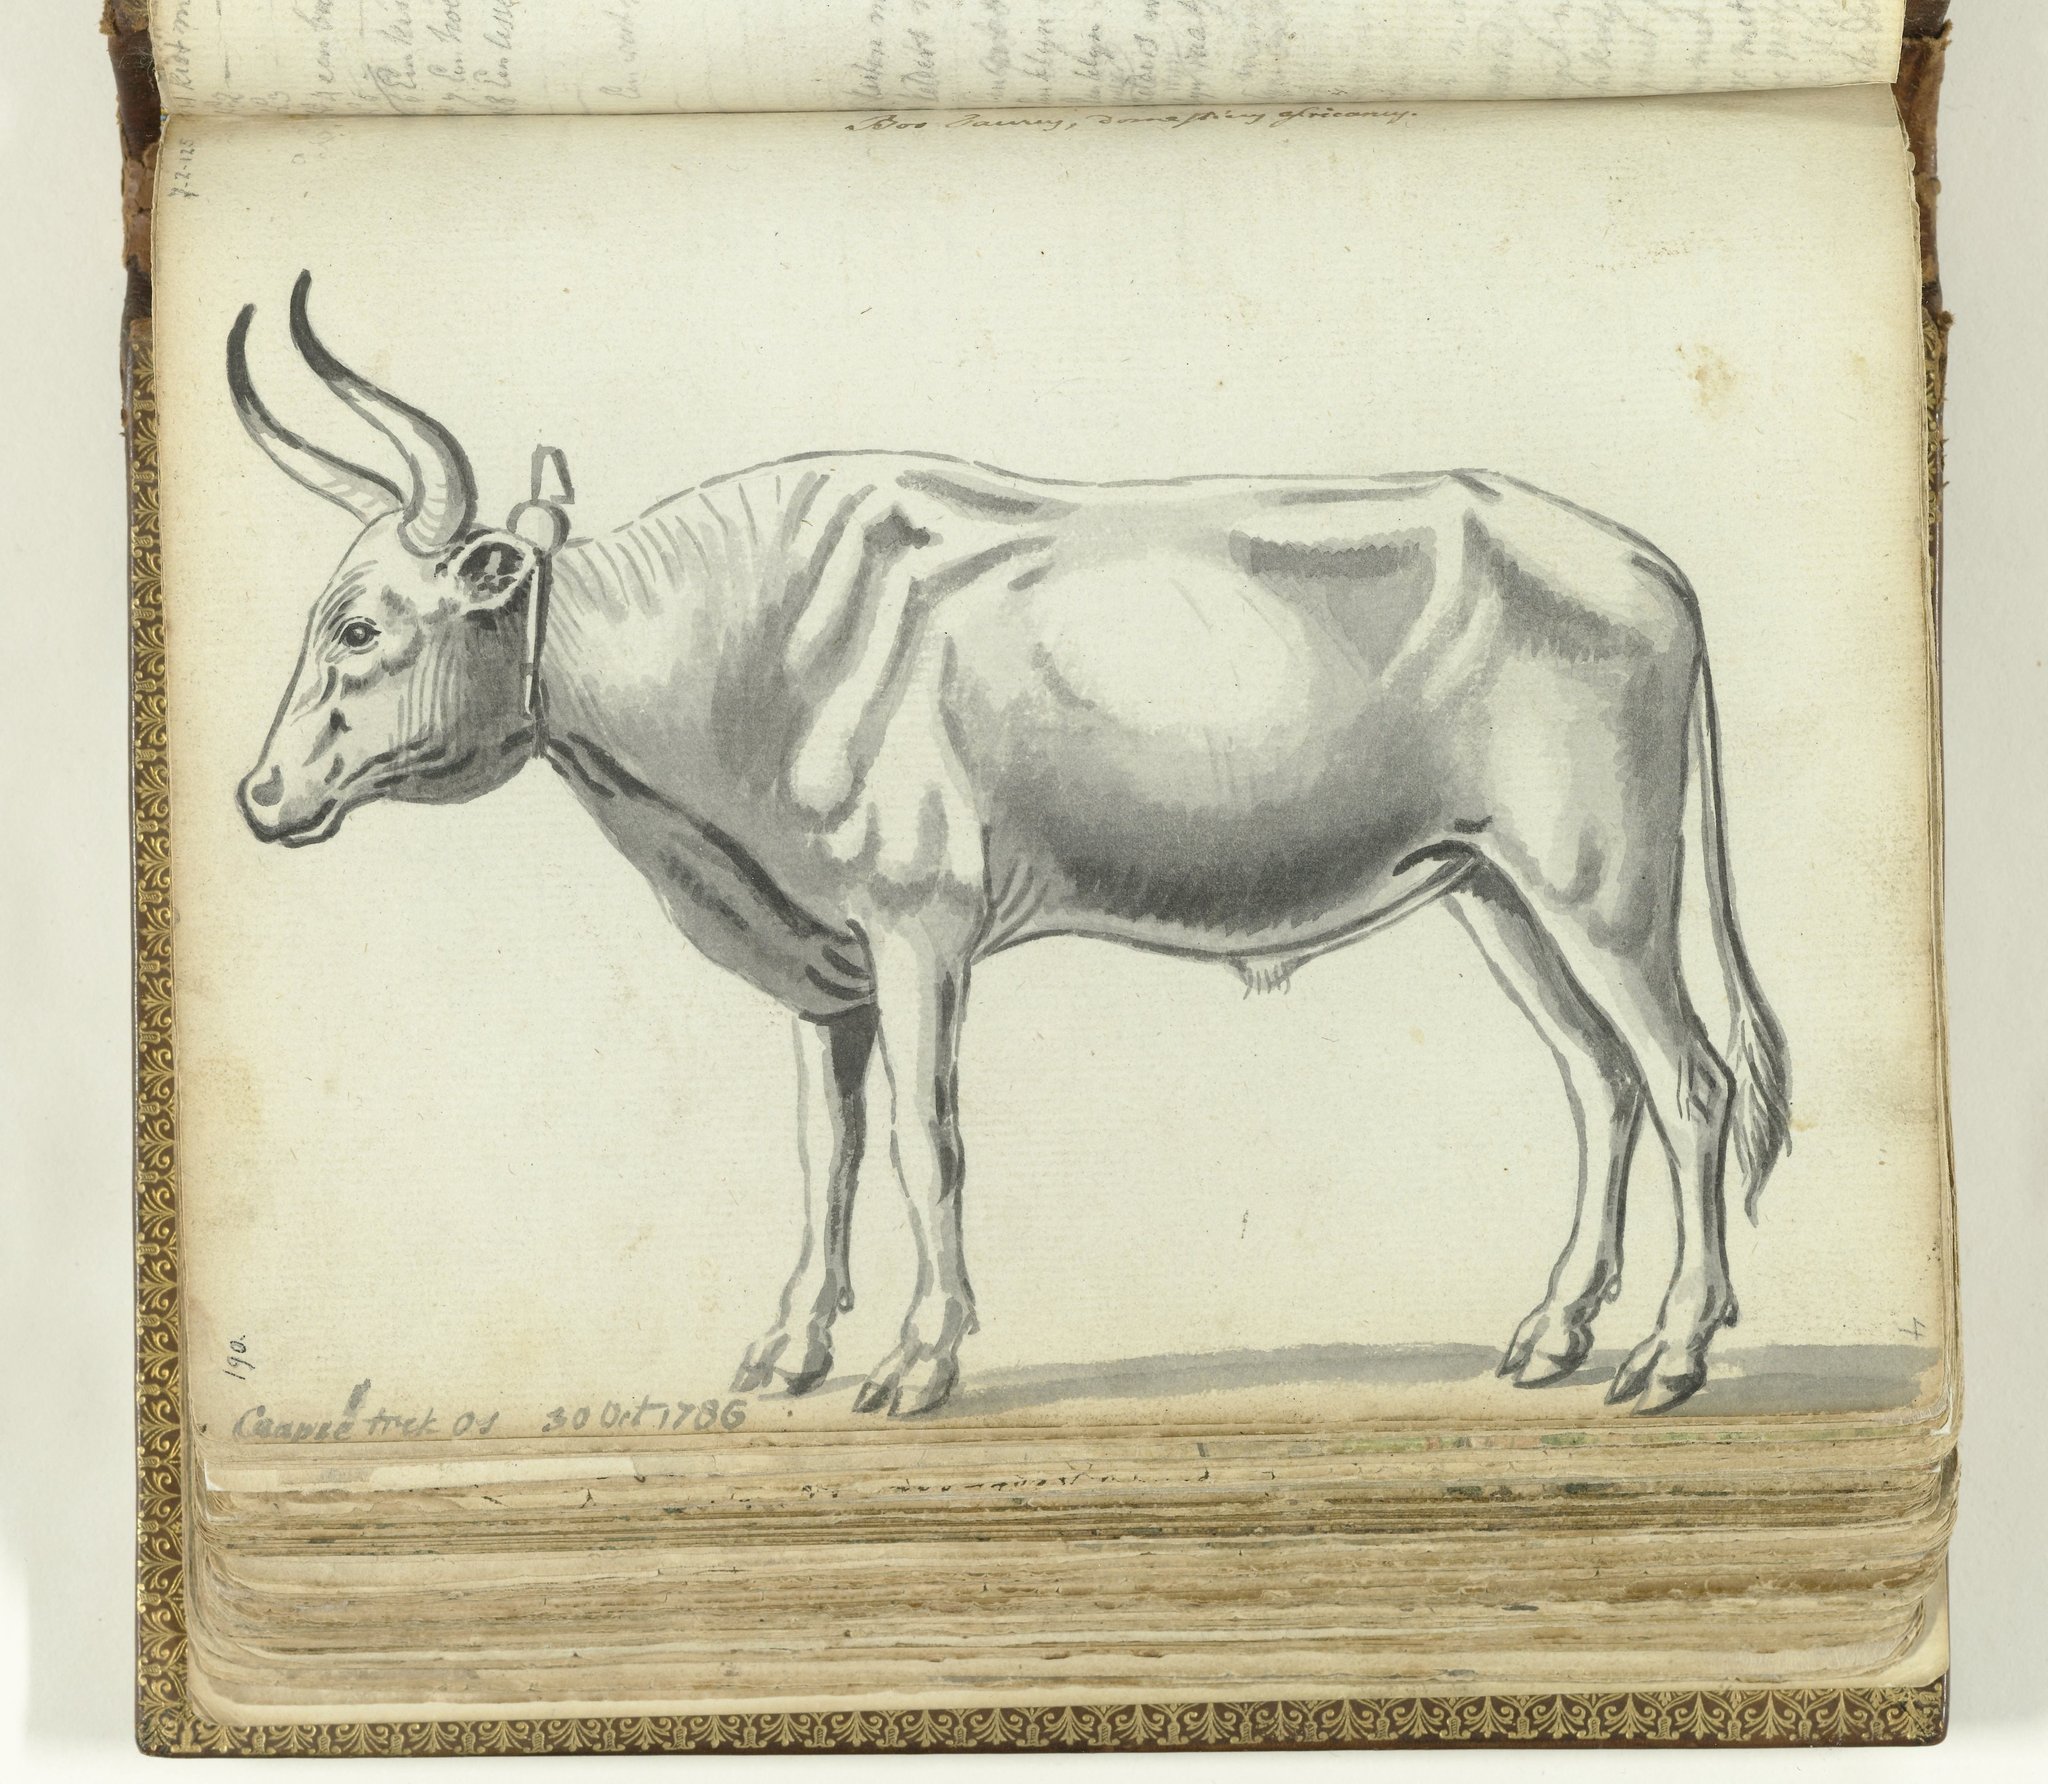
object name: drawing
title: Caapse trekos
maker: jan brandes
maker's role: draughtsman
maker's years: 1743-1808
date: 1786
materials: ink, paper, pencil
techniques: brush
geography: south africa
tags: ox, cape of good hope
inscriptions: inscription: ‘Caapse trek os 30 oct 1786.’, inscription: ‘Bos taurus, domesticus africanus.’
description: Zwartwittekening van een rund met een soort halster om zijn nek, zijaanzicht. Met opschrift. Onderdeel uit het schetsboek van Jan Brandes, dl. 2 (1808), p. 190.